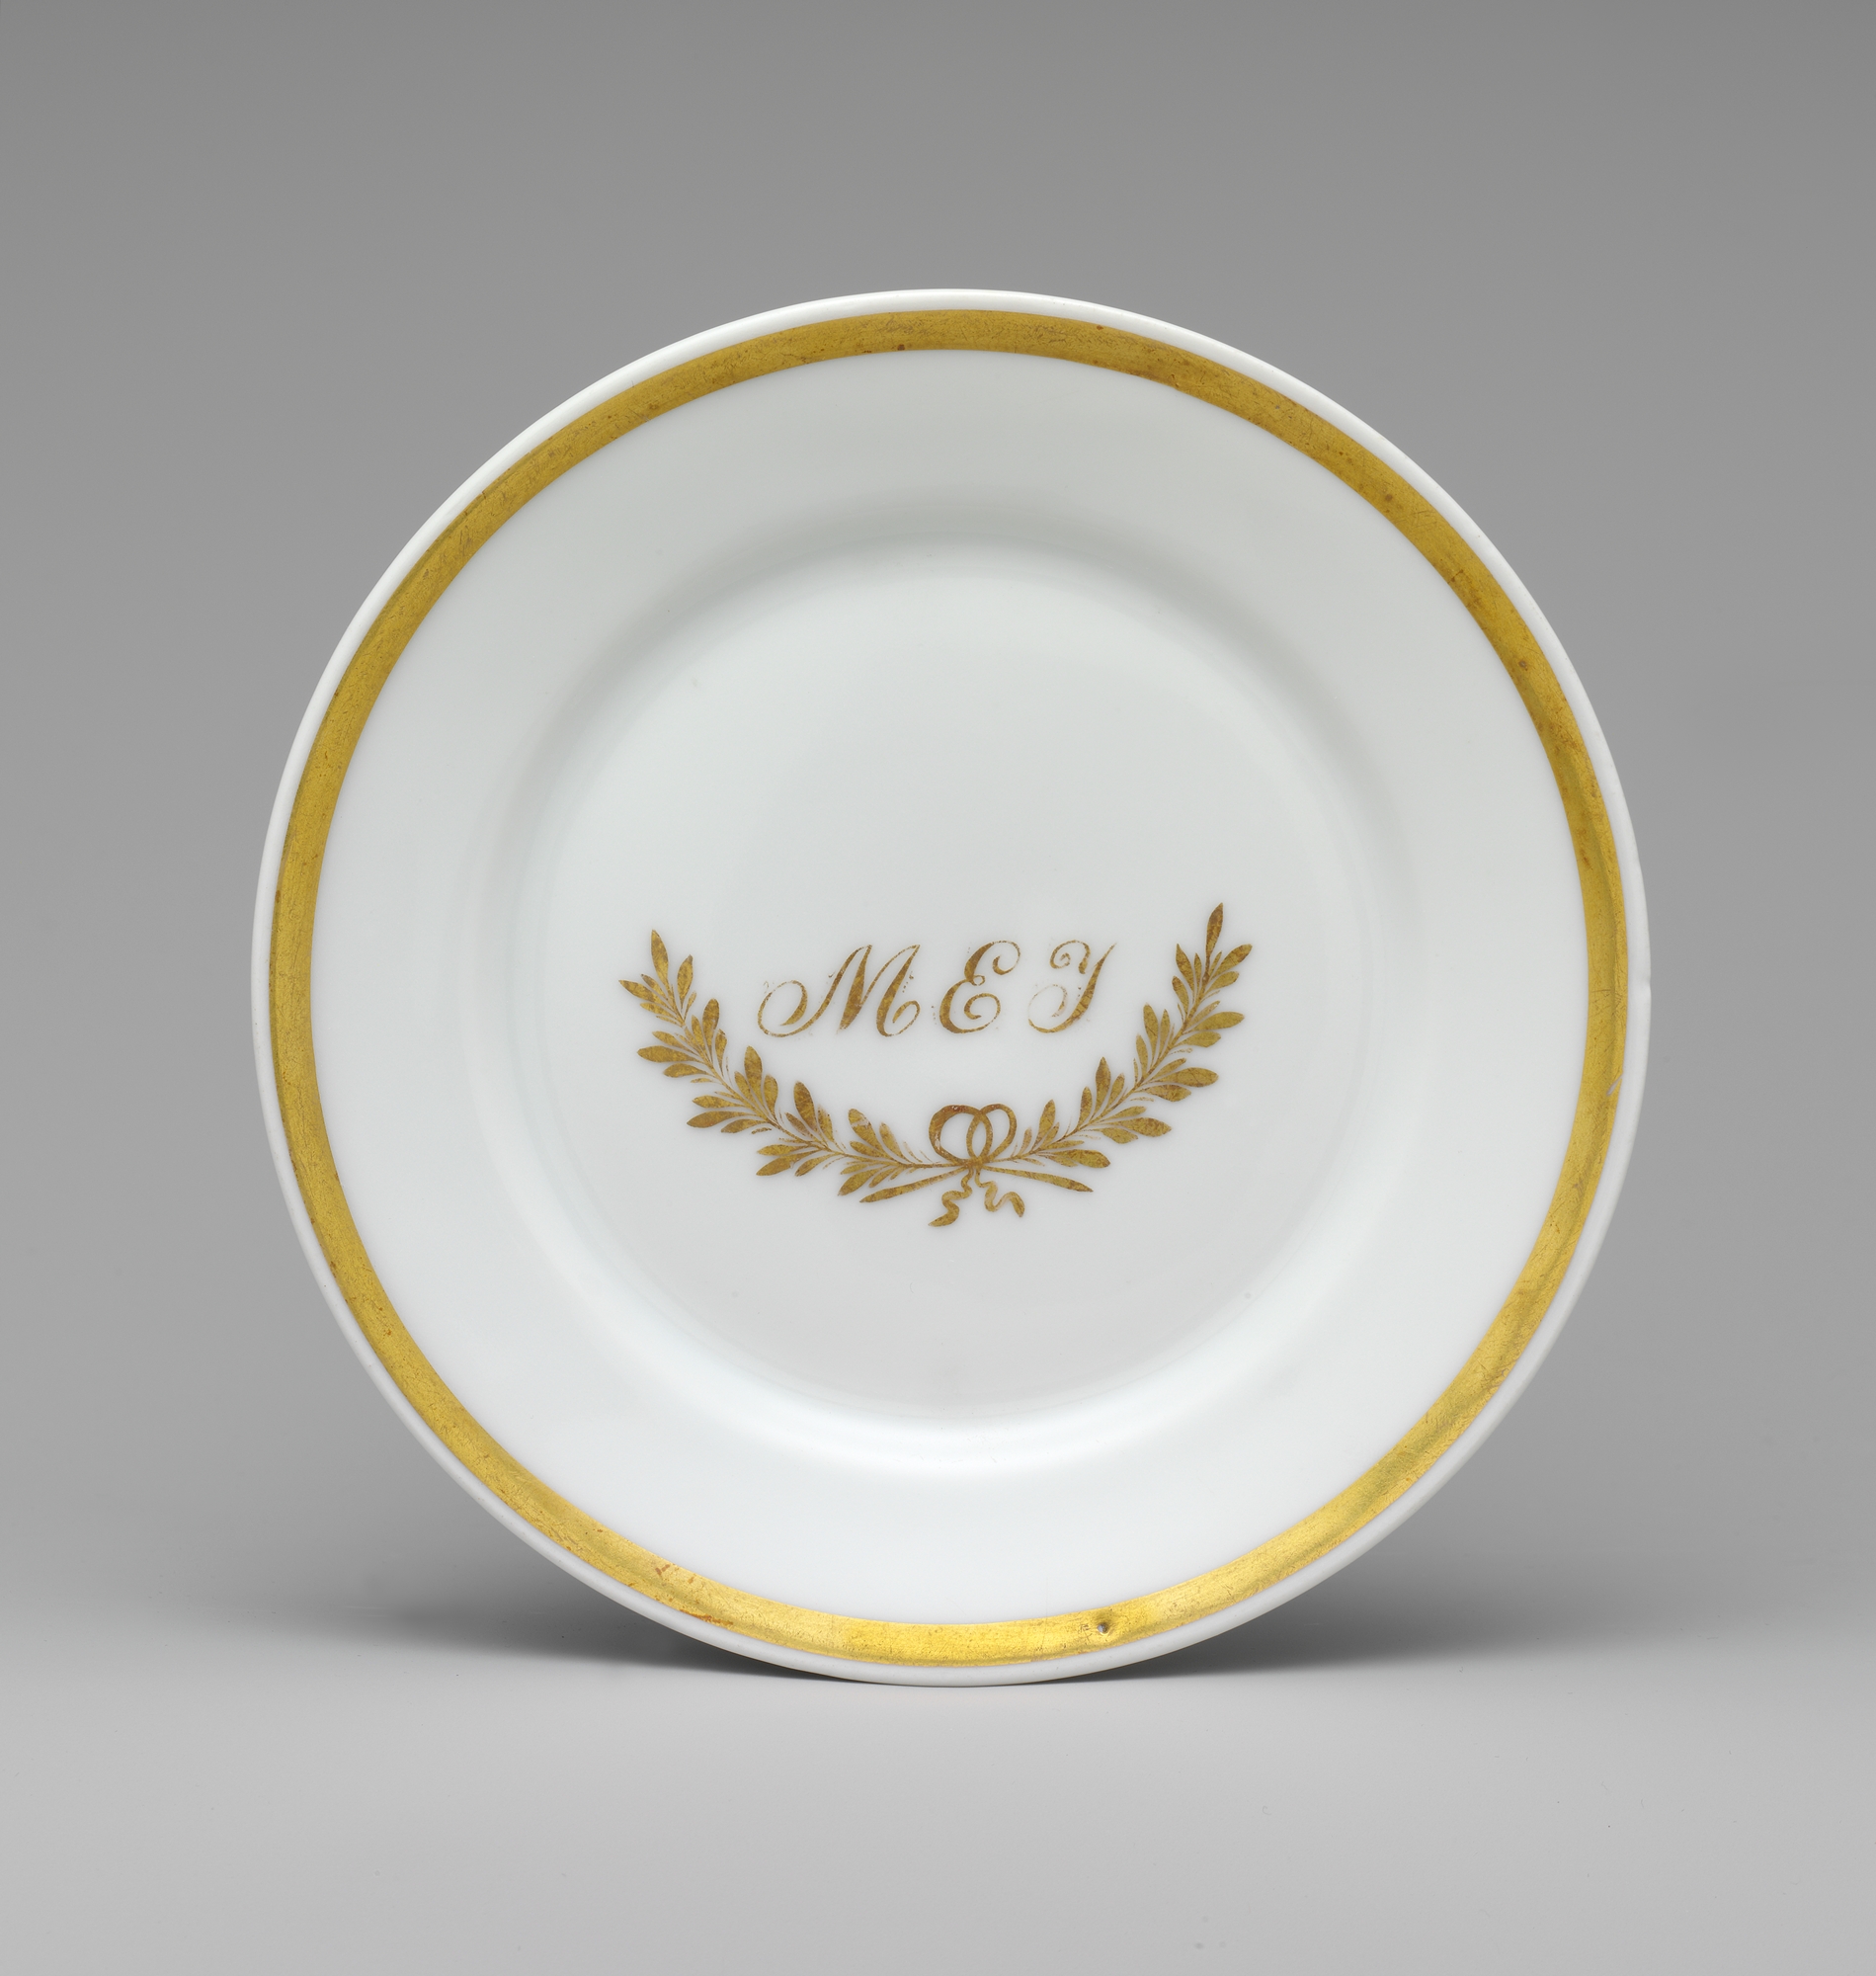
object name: plate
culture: american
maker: tucker and hemphill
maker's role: maker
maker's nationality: american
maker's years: 1831-1837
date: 1838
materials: porcelain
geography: united states